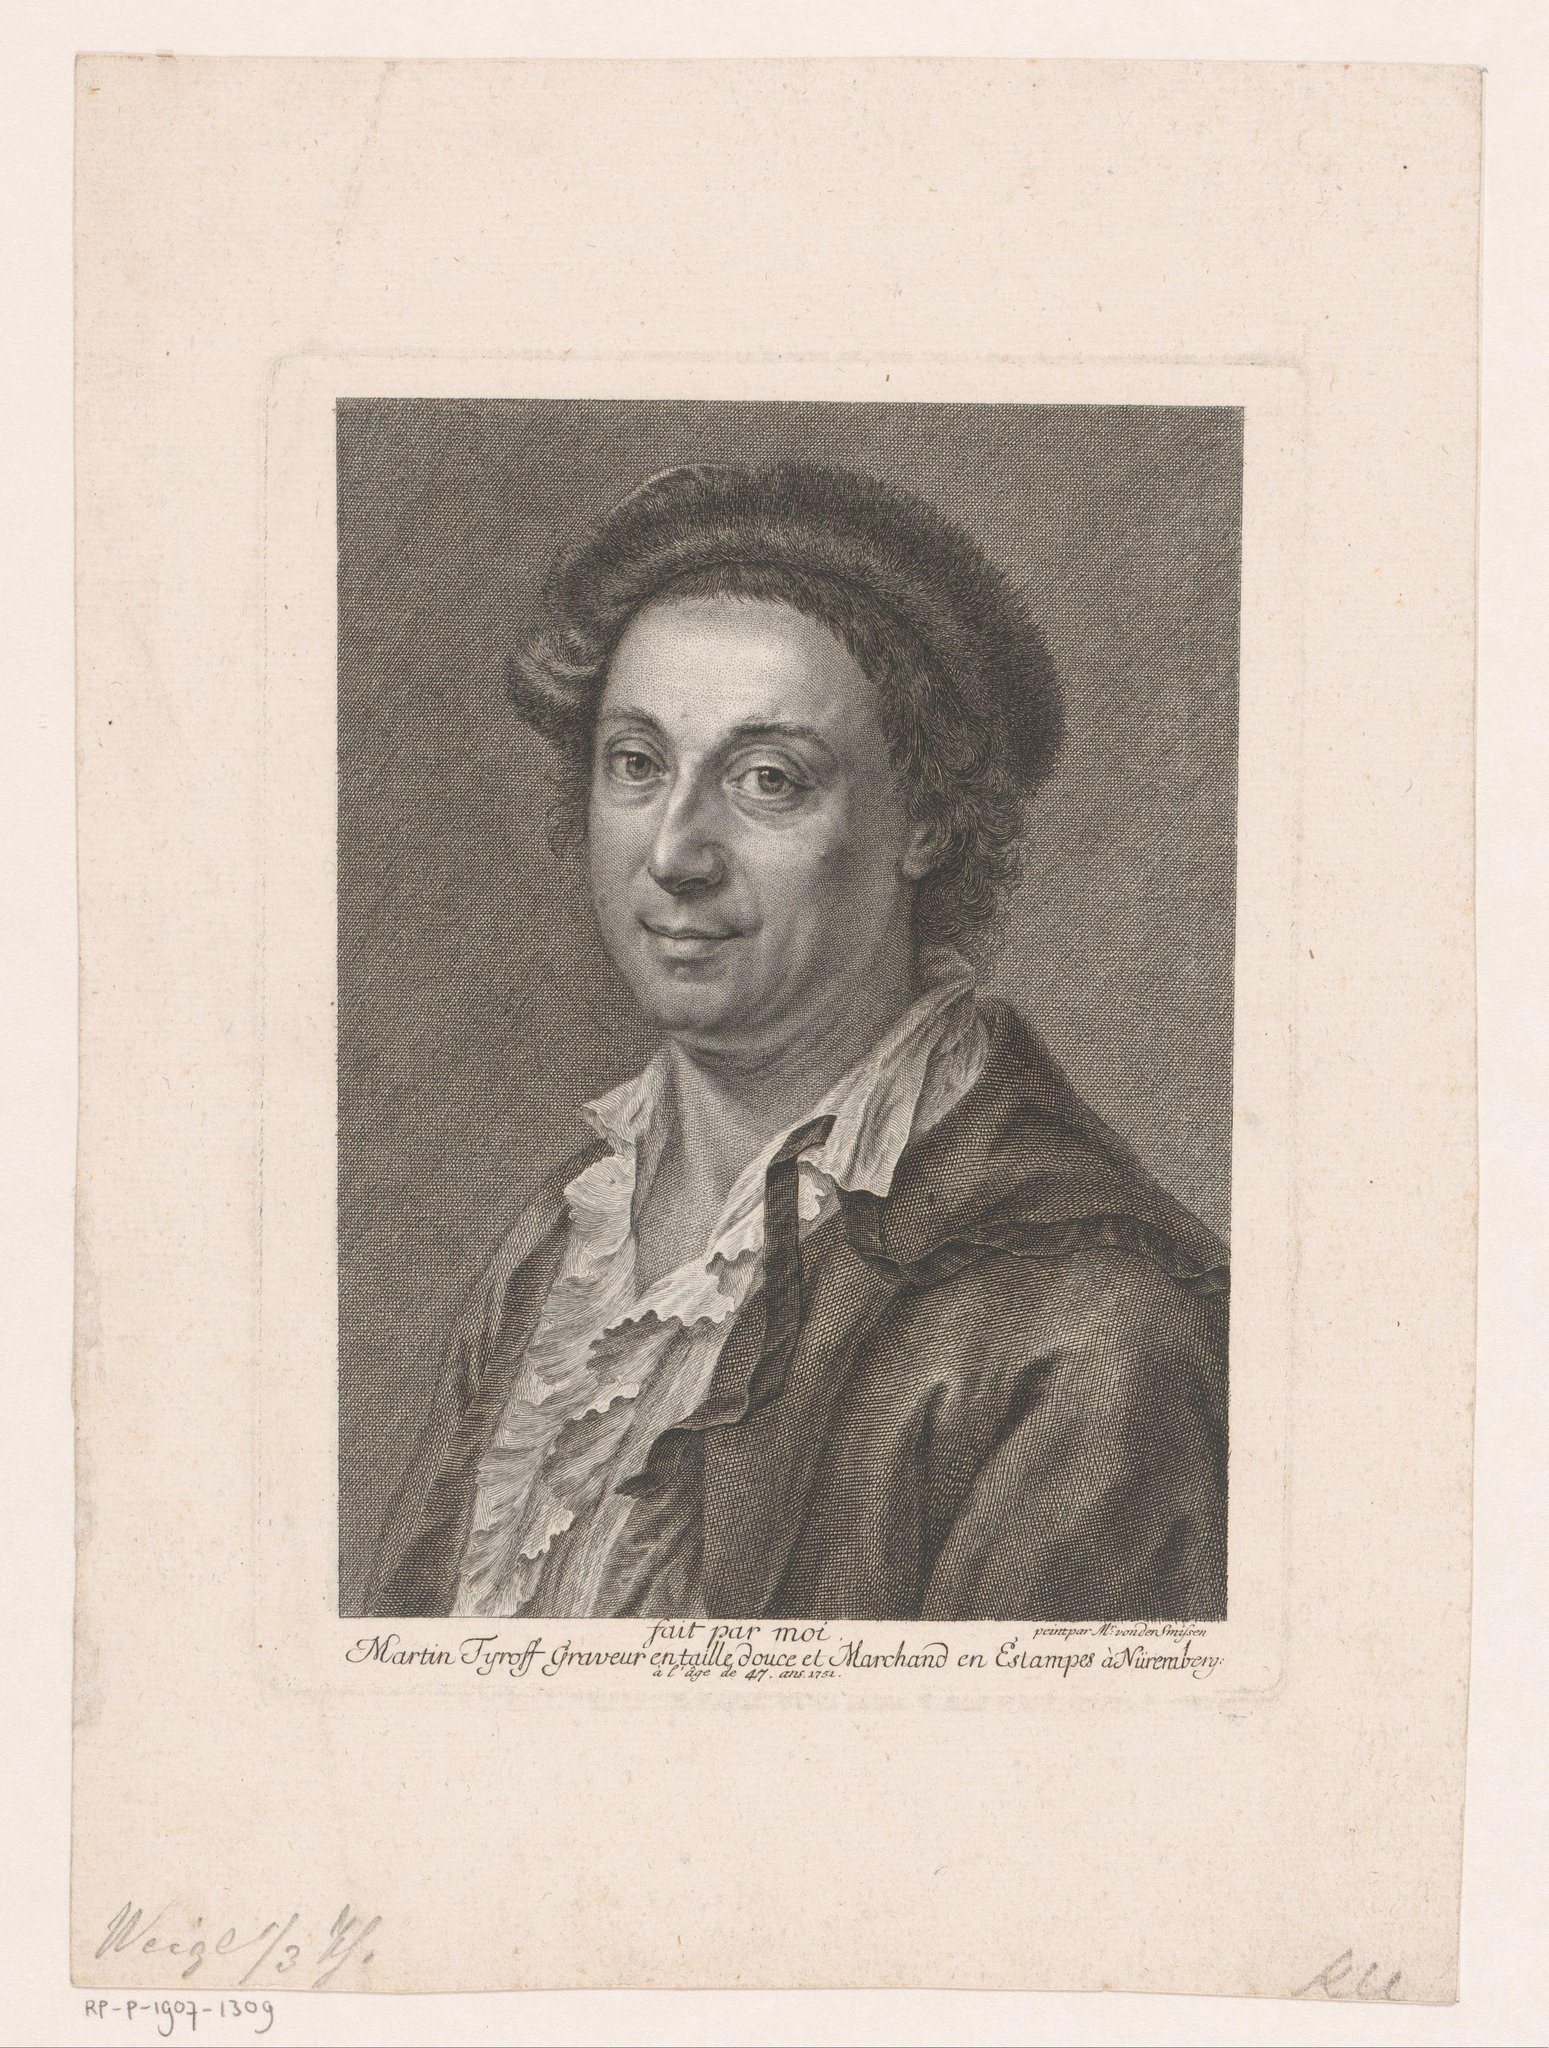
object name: print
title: Zelfportret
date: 1751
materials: paper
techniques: engraving, etching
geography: nuremberg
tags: augsburg, publisher, martin tyroff, historical persons, portrait, self-portrait of artist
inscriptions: collector's mark: Lugt 2228